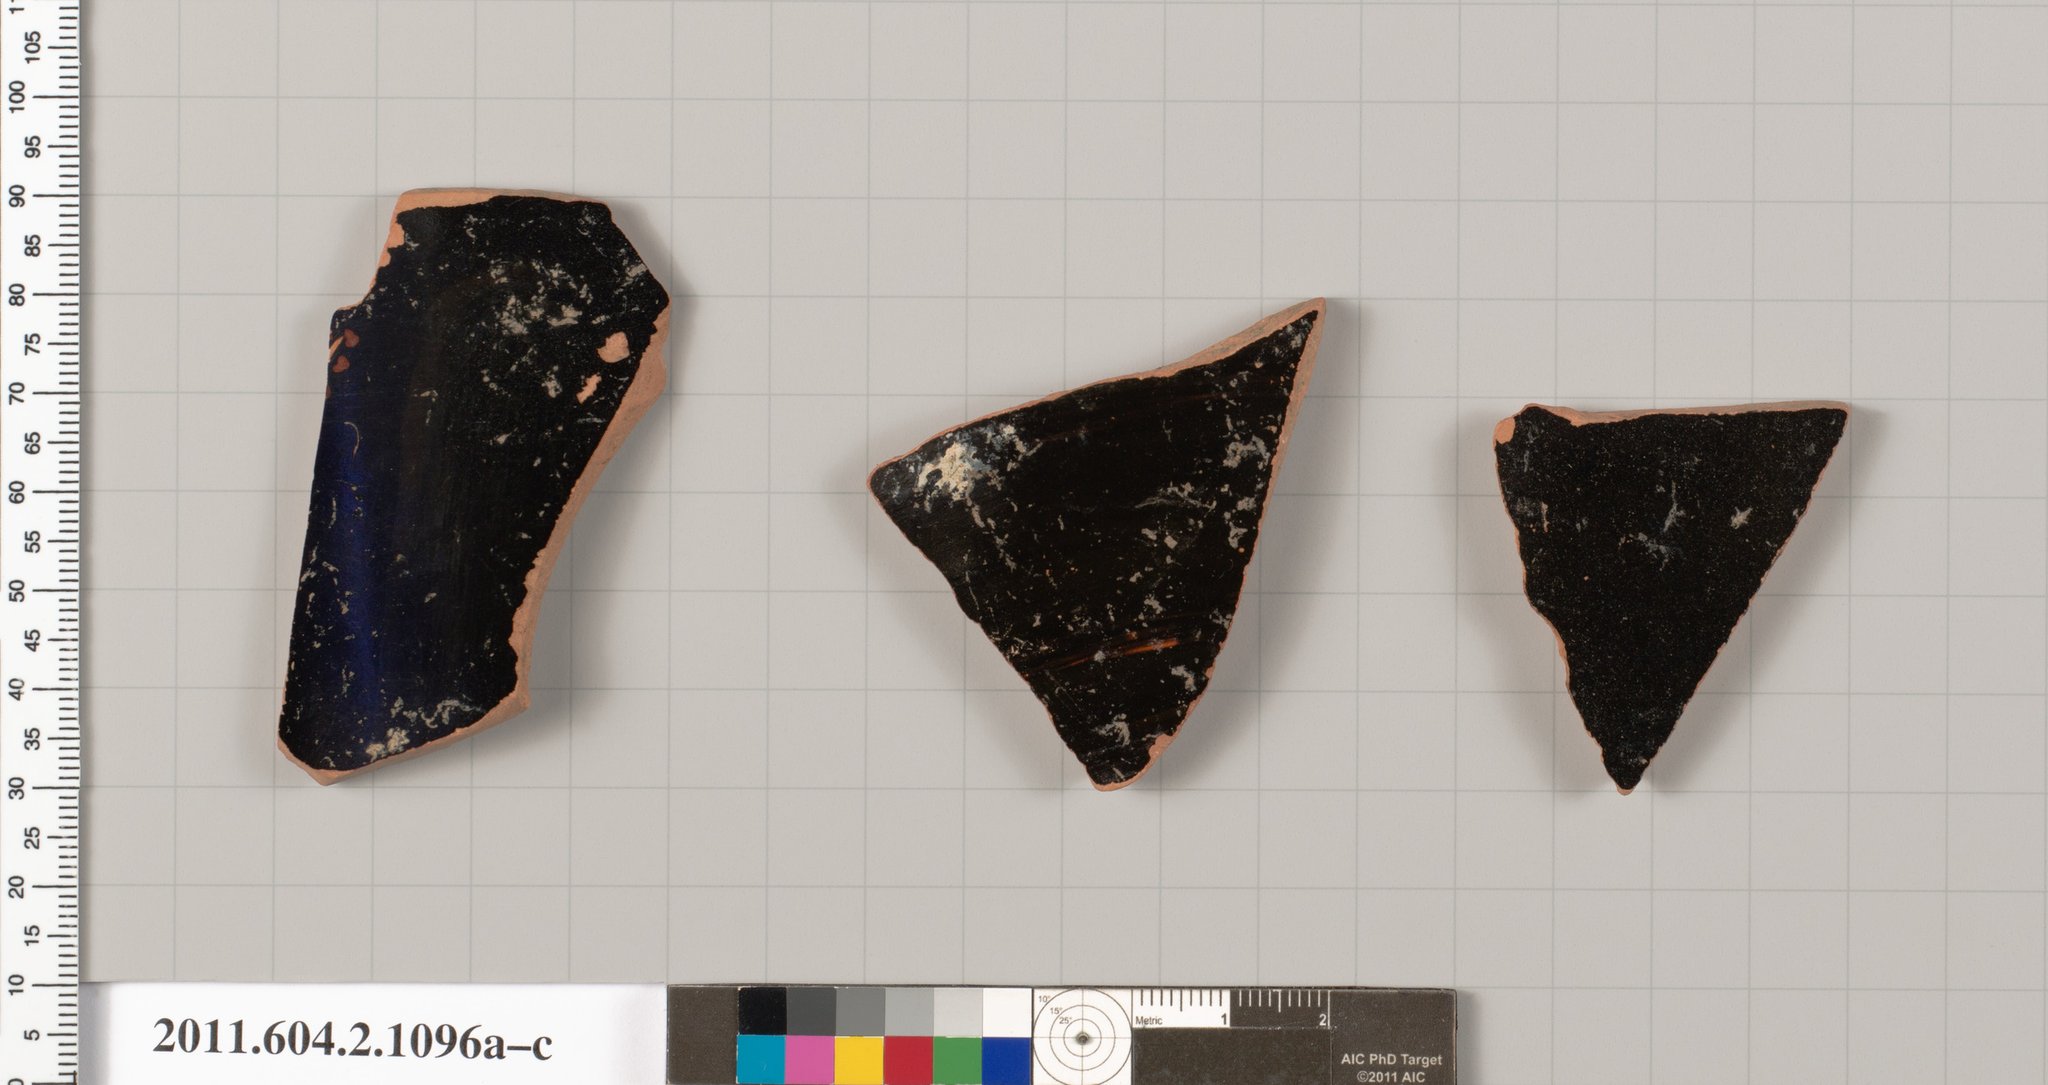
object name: lekythos fragment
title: Terracotta fragments of lekythoi (oil flasks)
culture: greek, attic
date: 500-451 BCE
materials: terracotta